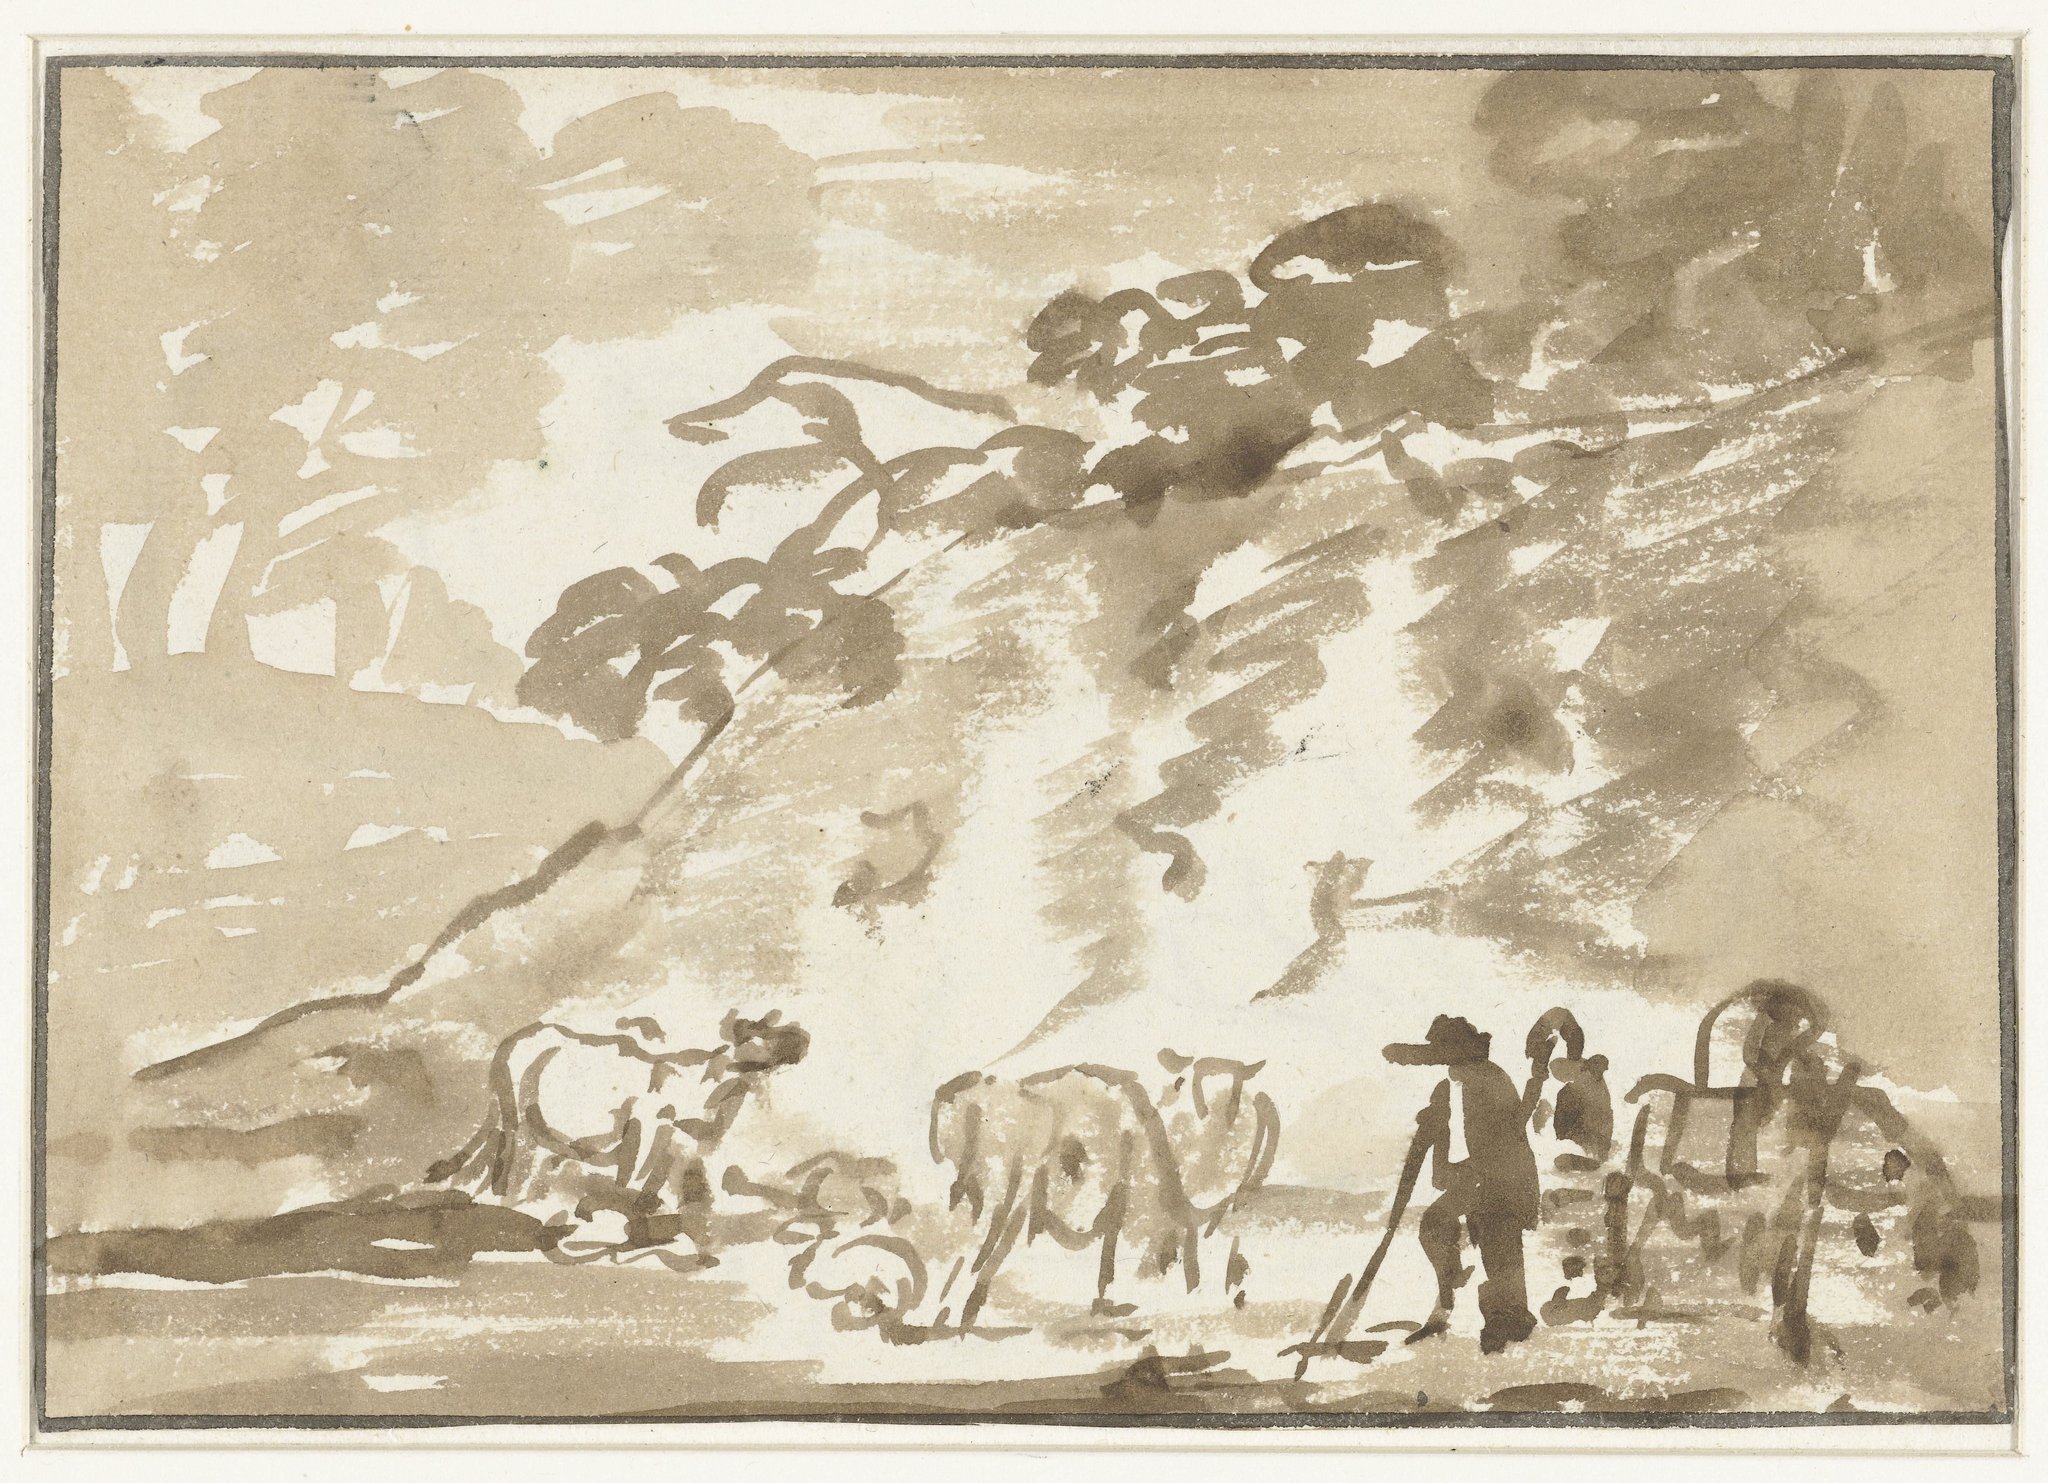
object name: drawing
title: Landschap met koeien en een herder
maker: jacob van strij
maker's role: draughtsman, painter, print maker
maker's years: 1756-1815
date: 1766-1815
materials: paper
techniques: brush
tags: landscapes, herding, herdsman, herdswoman, shepherd, shepherdess, cowherd, etc., bovine cattle